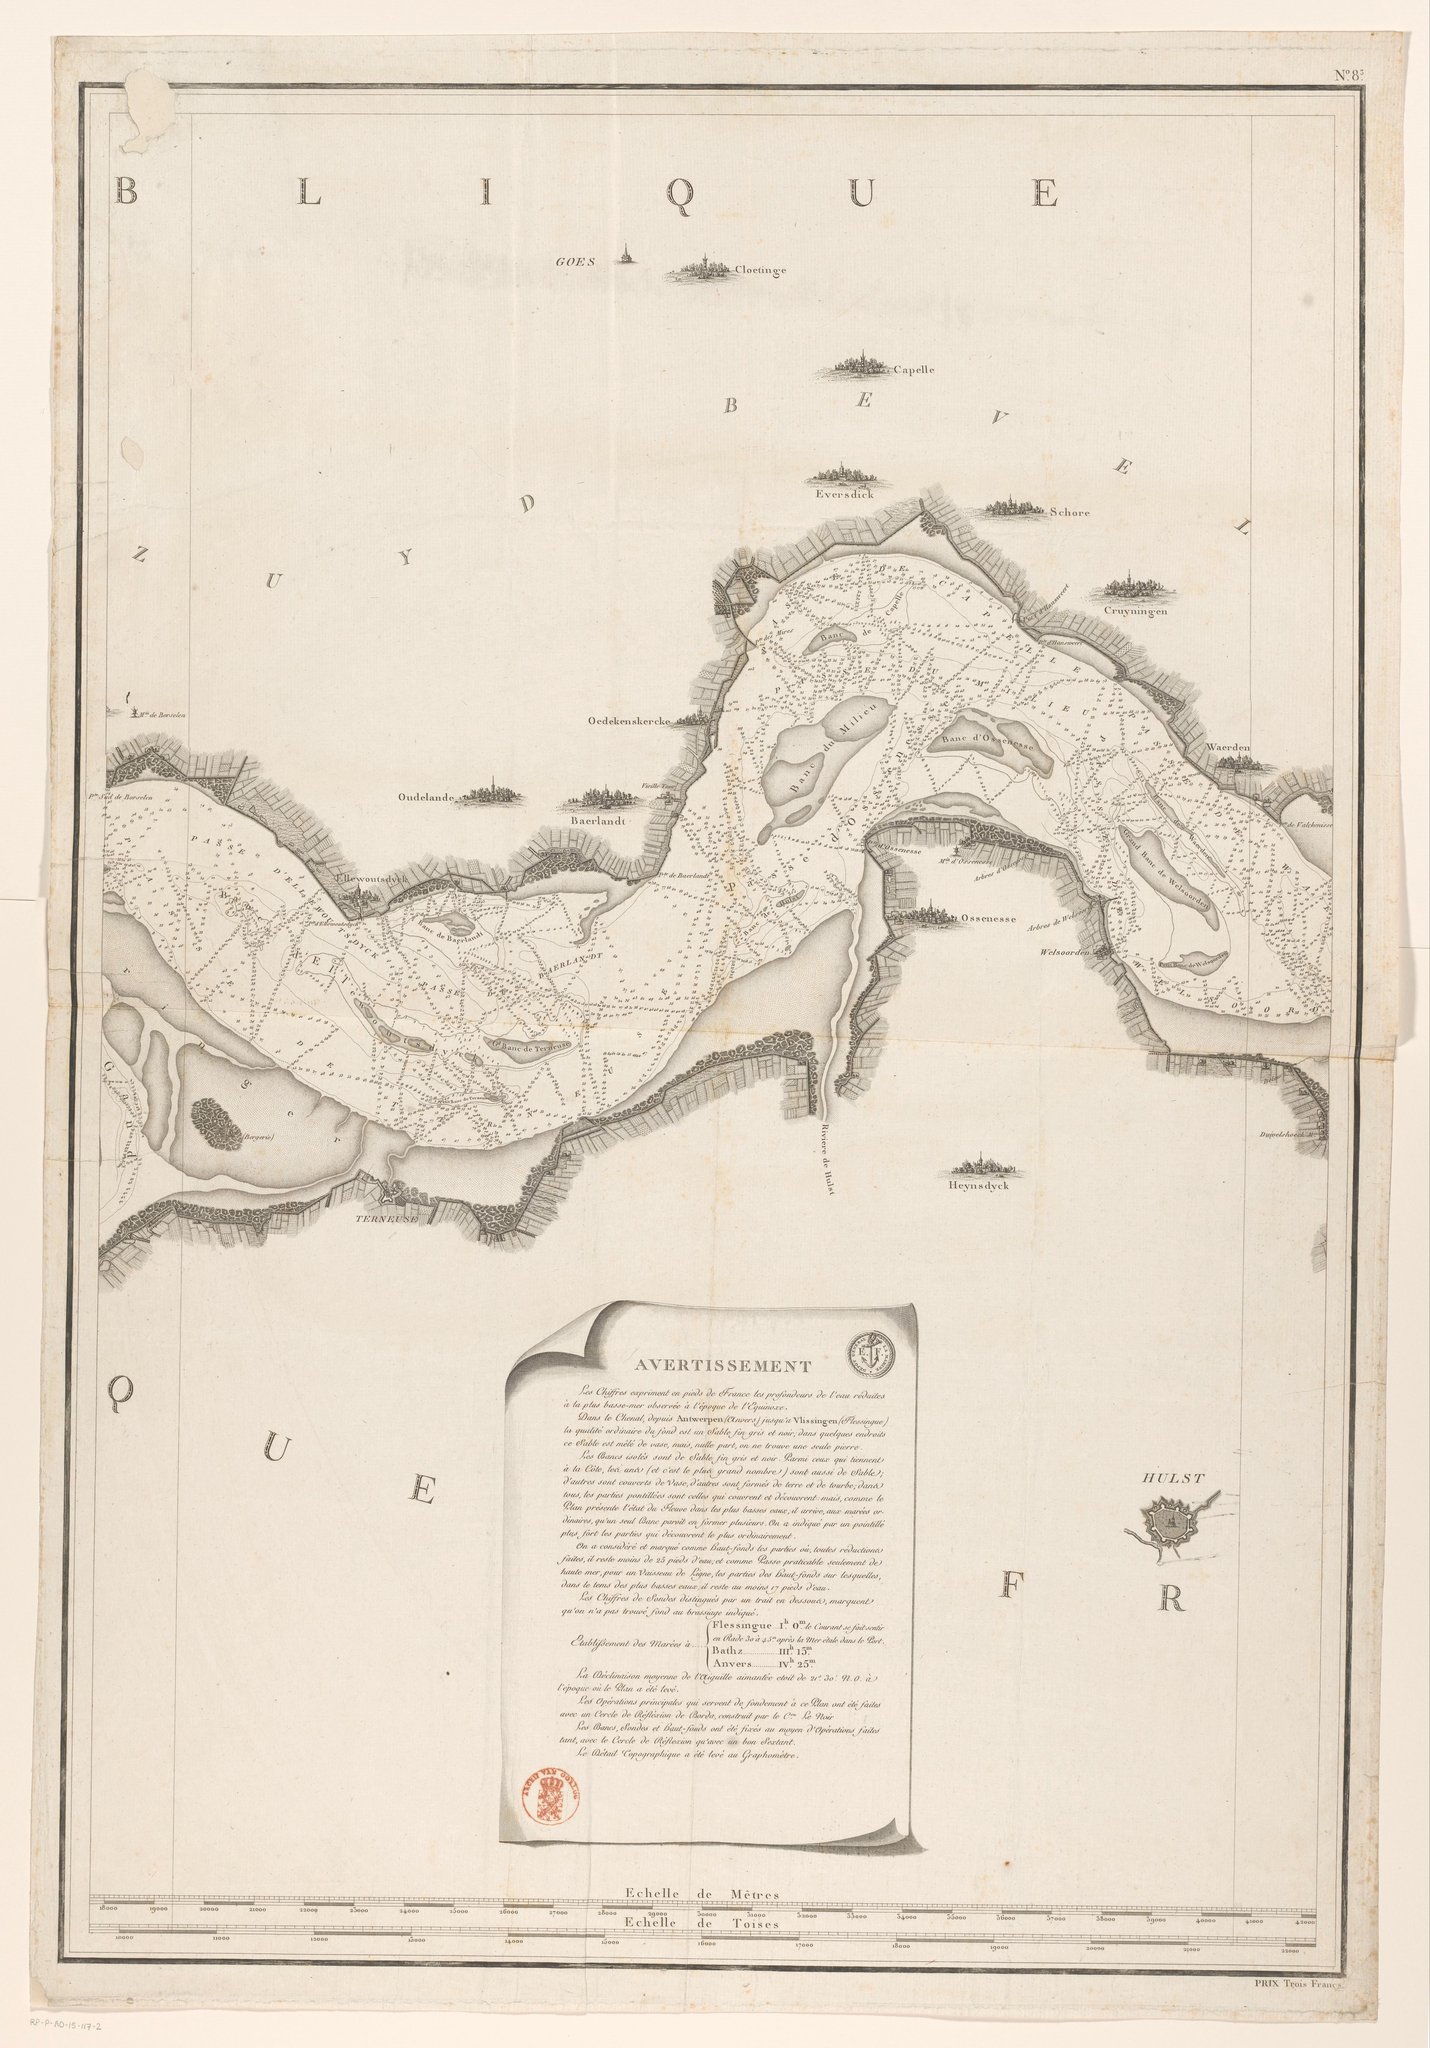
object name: print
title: Kaart van de Westerschelde (tweede deel)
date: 1799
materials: paper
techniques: engraving, etching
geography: france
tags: maps of separate countries or regions, zeeland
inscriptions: collector's mark: Lugt 19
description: Tweede deel van een kaart van de Westerschelde, bestaande uit drie delen. Rechtsboven genummerd: No. 8.3.